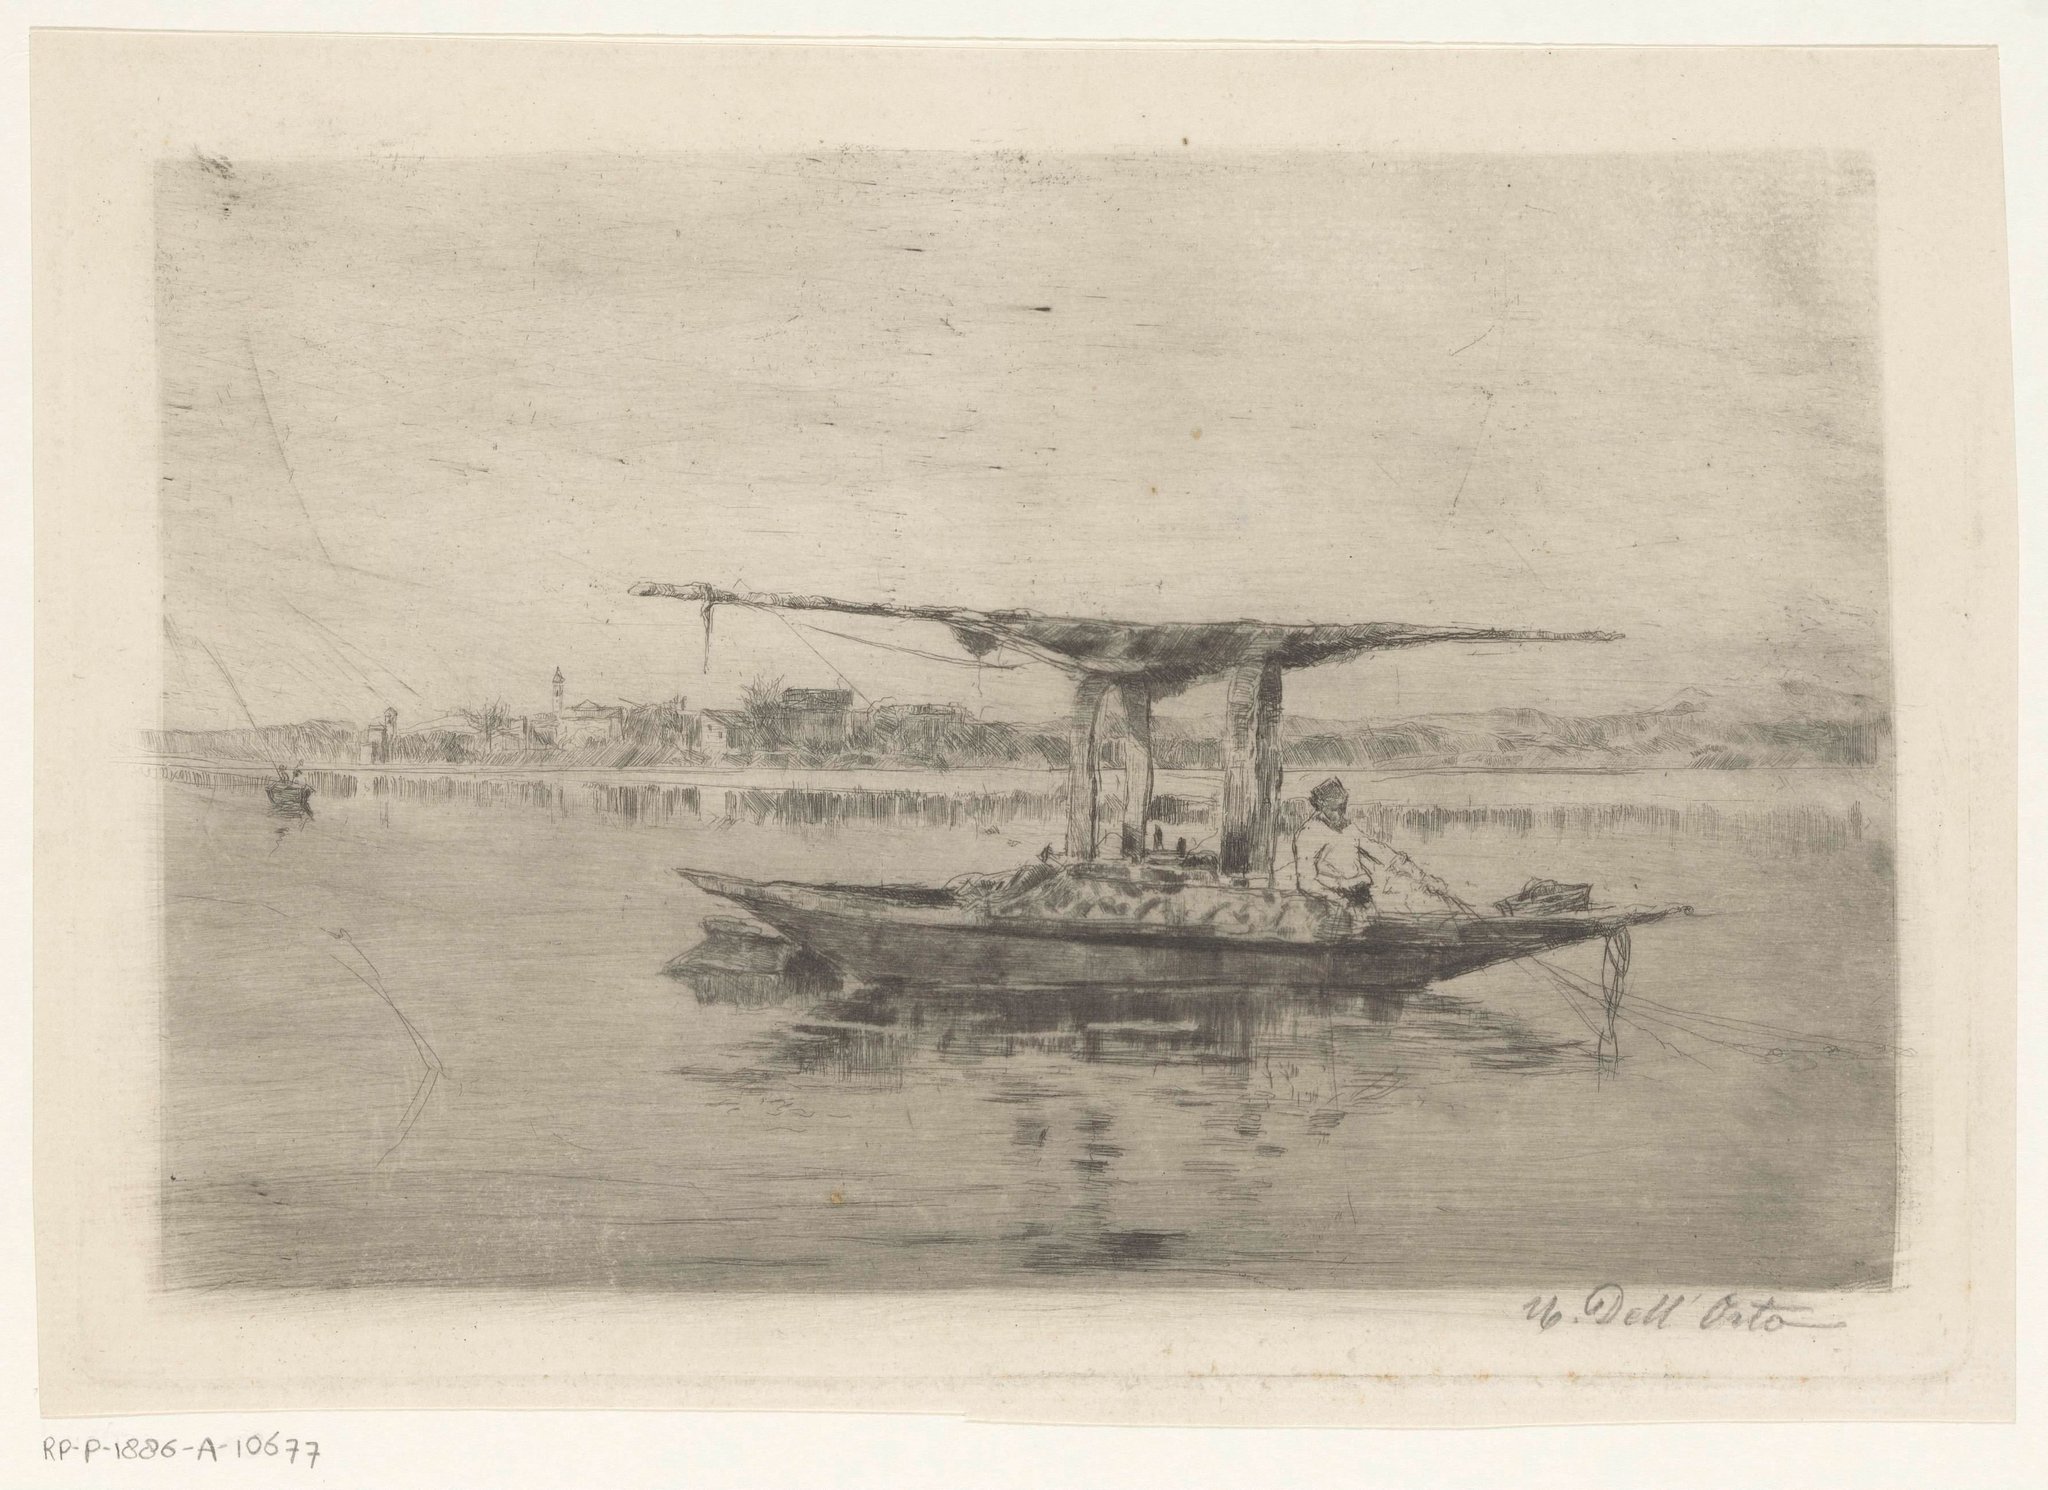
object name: print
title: Visser op een rivier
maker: uberto dell orto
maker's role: painter, print maker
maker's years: 1848-1895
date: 1858-1886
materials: paper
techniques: aquatint, drypoint, etching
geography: italy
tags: city-view, and landscape with man-made constructions, river, fisherman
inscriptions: collector's mark: Lugt 2228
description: Op een kalme rivier vaart een visser, in zijn hand houdt hij een aantal vislijnen. Op de achtergrond de oever en een aan het water gelegen dorp.